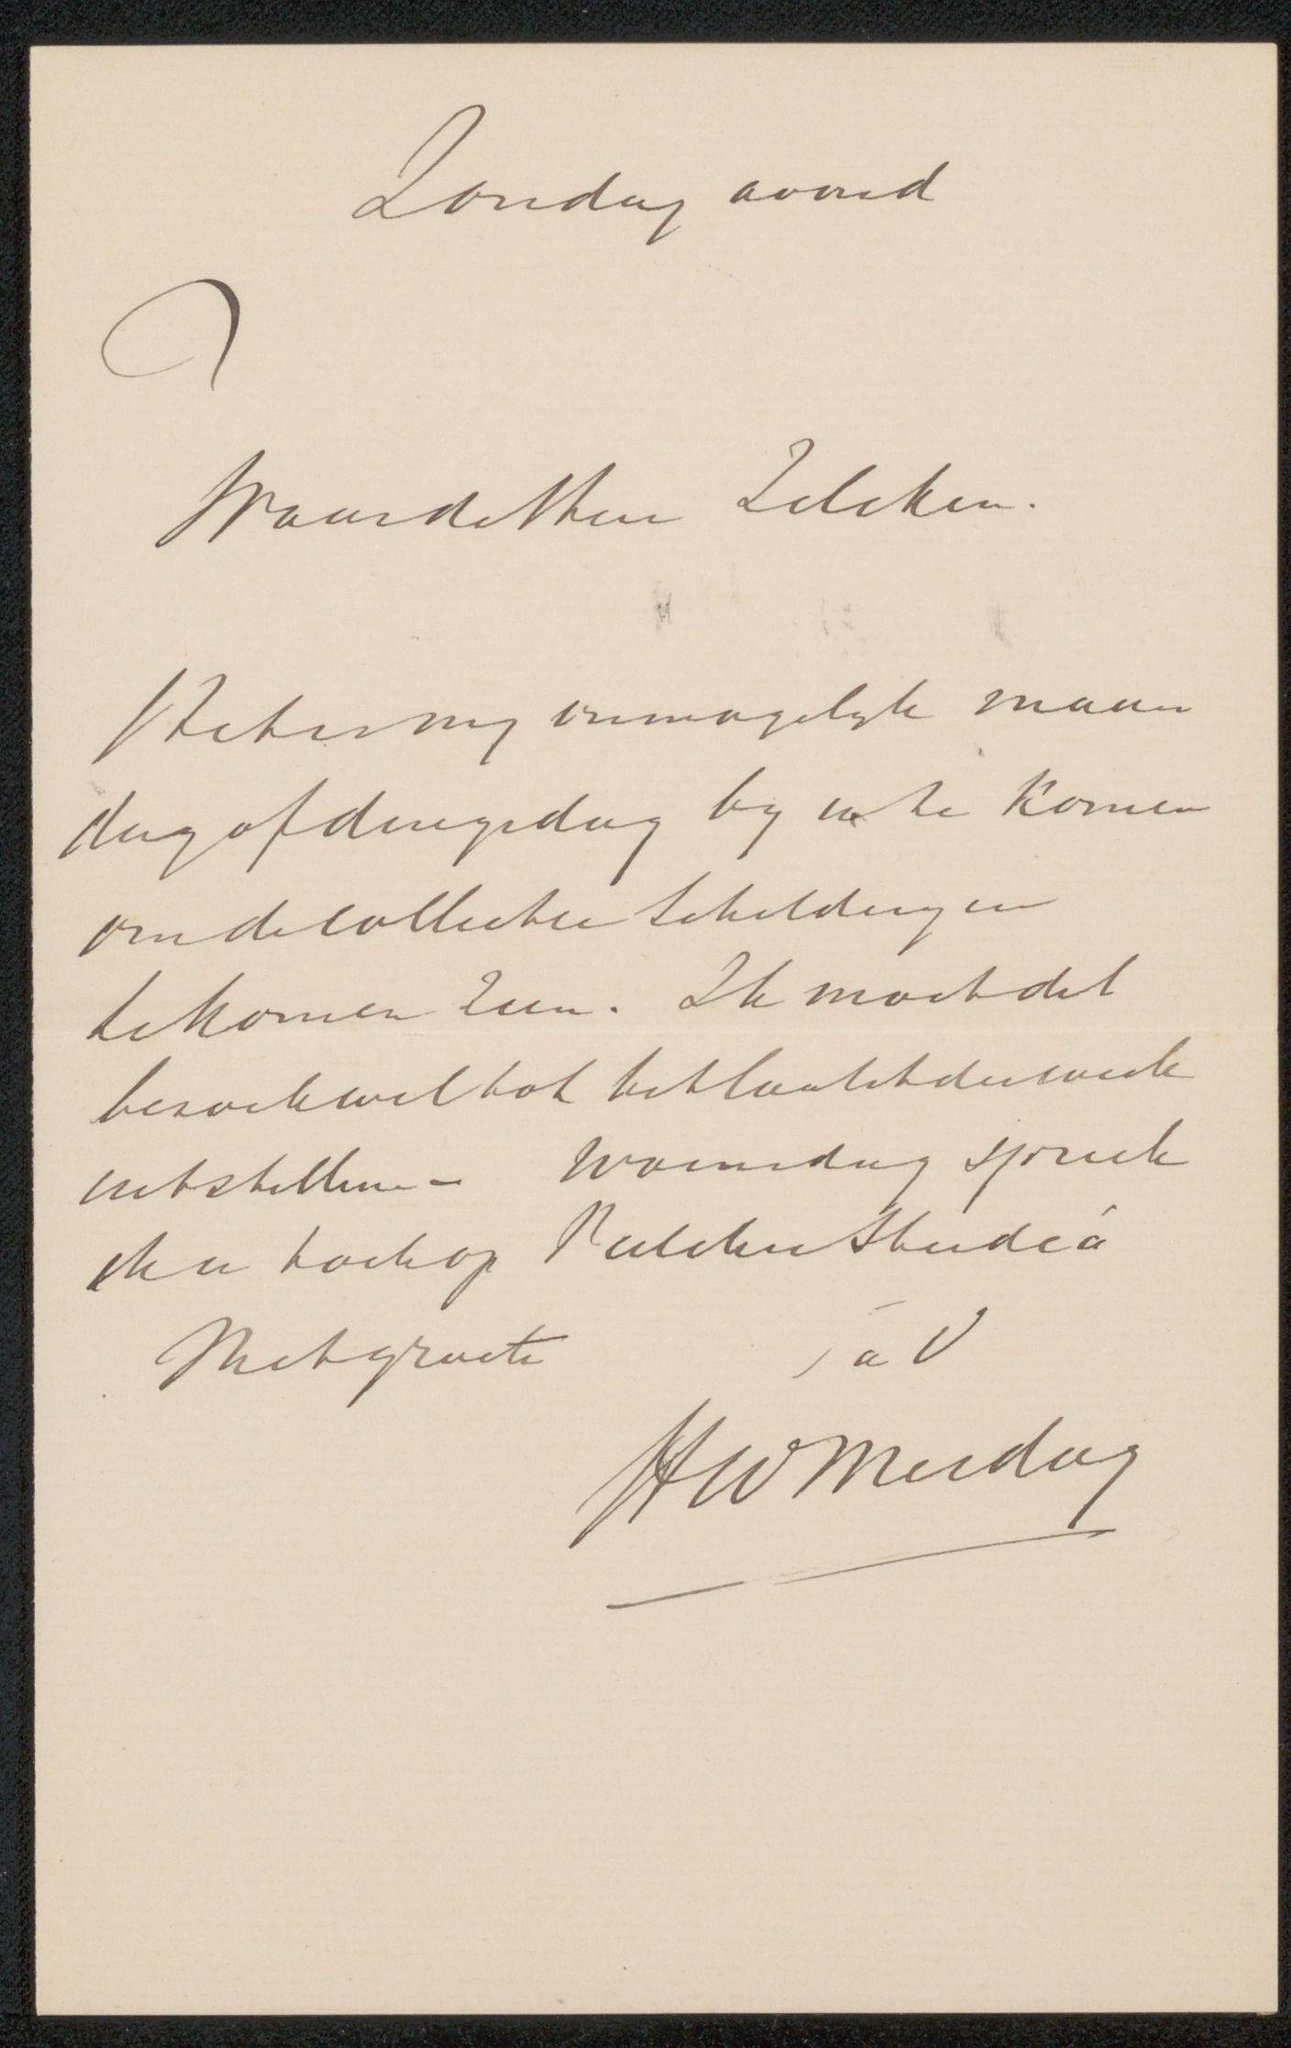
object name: letter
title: Brief aan Philip Zilcken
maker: hendrik willem mesdag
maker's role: draughtsman, painter, print maker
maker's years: 1831-1915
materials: ink, paper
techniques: pen, writing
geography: the hague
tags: philip zilcken, painting (including book-illumination, miniature-painting)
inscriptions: watermark